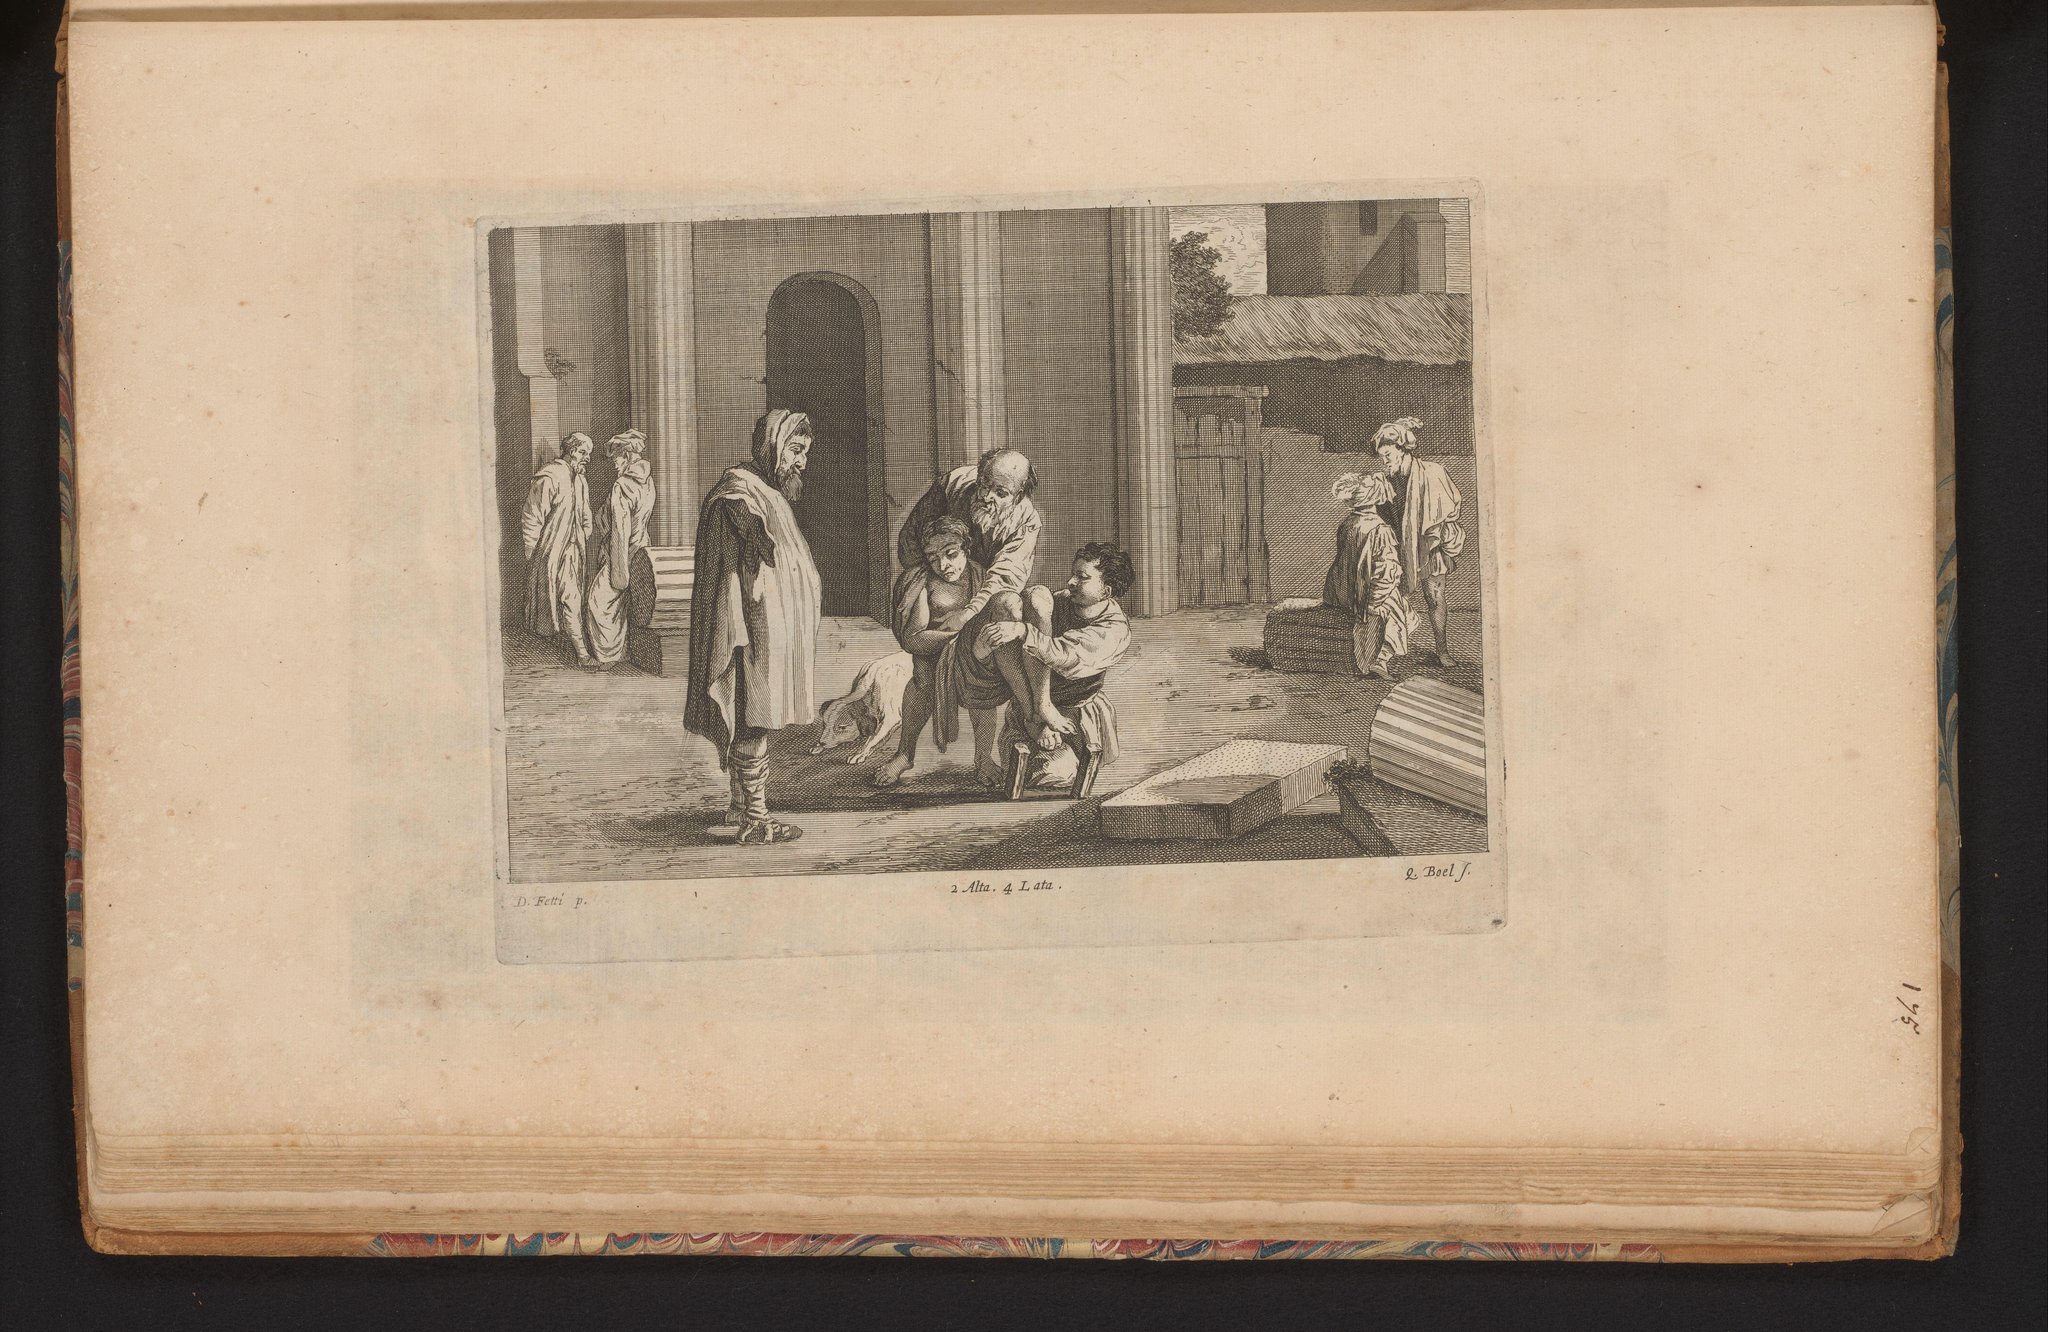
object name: album leaf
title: Tobit en Tobias begraven de Israëliet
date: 1660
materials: paper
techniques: etching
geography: italy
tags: tobit buries a dead man at night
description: David Teniers heeft waarschijnlijk van alle schilderijen uit de collectie van Leopold Willem van Oostenrijk een olieverfstudie op doek of paneel vervaardigd (zgn. pasticcio), die als voorbeeld voor de prentmakers diende. Het is niet altijd duidelijk of de pasticci door hem zijn gemaakt of door zijn atelier. Niet alle pasticci zijn overgeleverd.